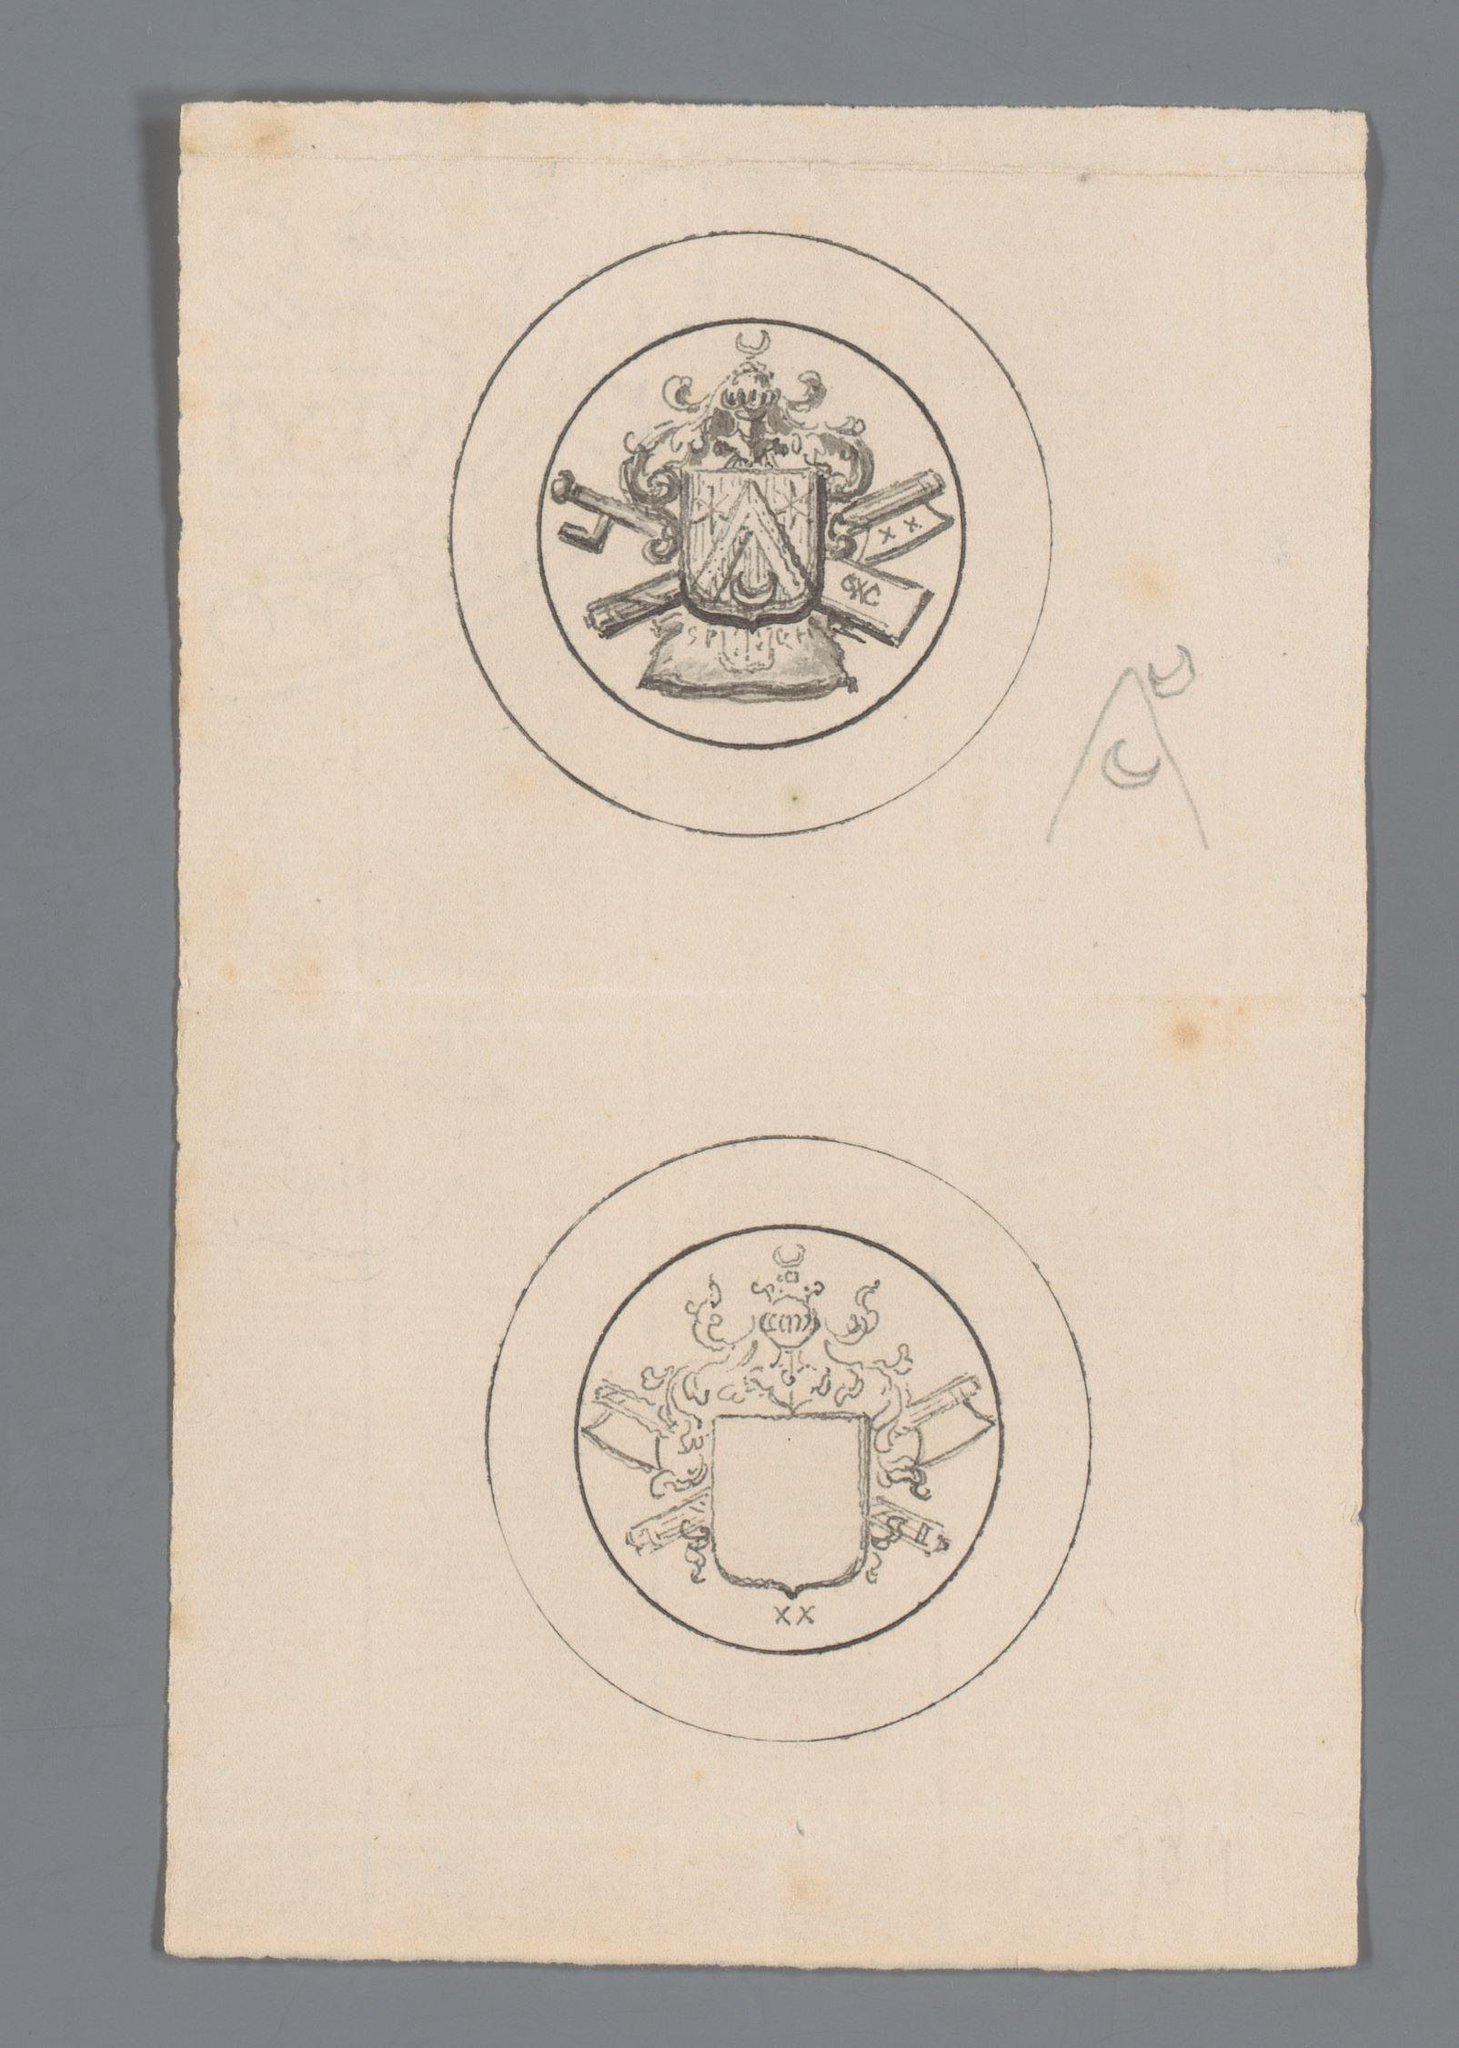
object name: drawing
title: Ontwerpen voor een historiepenning voor raad, schepen en oud-burgemeester van Haarlem Pieter van der Camer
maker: Anonymous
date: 1743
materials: ink, paper, pencil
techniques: brush, pen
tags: armorial bearing, heraldry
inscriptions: collector's mark: Lugt 2228a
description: Bovenaan een ontwerp met het wapen van Pieter van der Camer boven een kussen en achter het wapen twee gekruiste fasces (of bijlbundels: bundels houten pijlen die een bijl insluiten). Onderaan een ontwerp met een blanco wapenschild en daarachter twee gekruiste fasces.